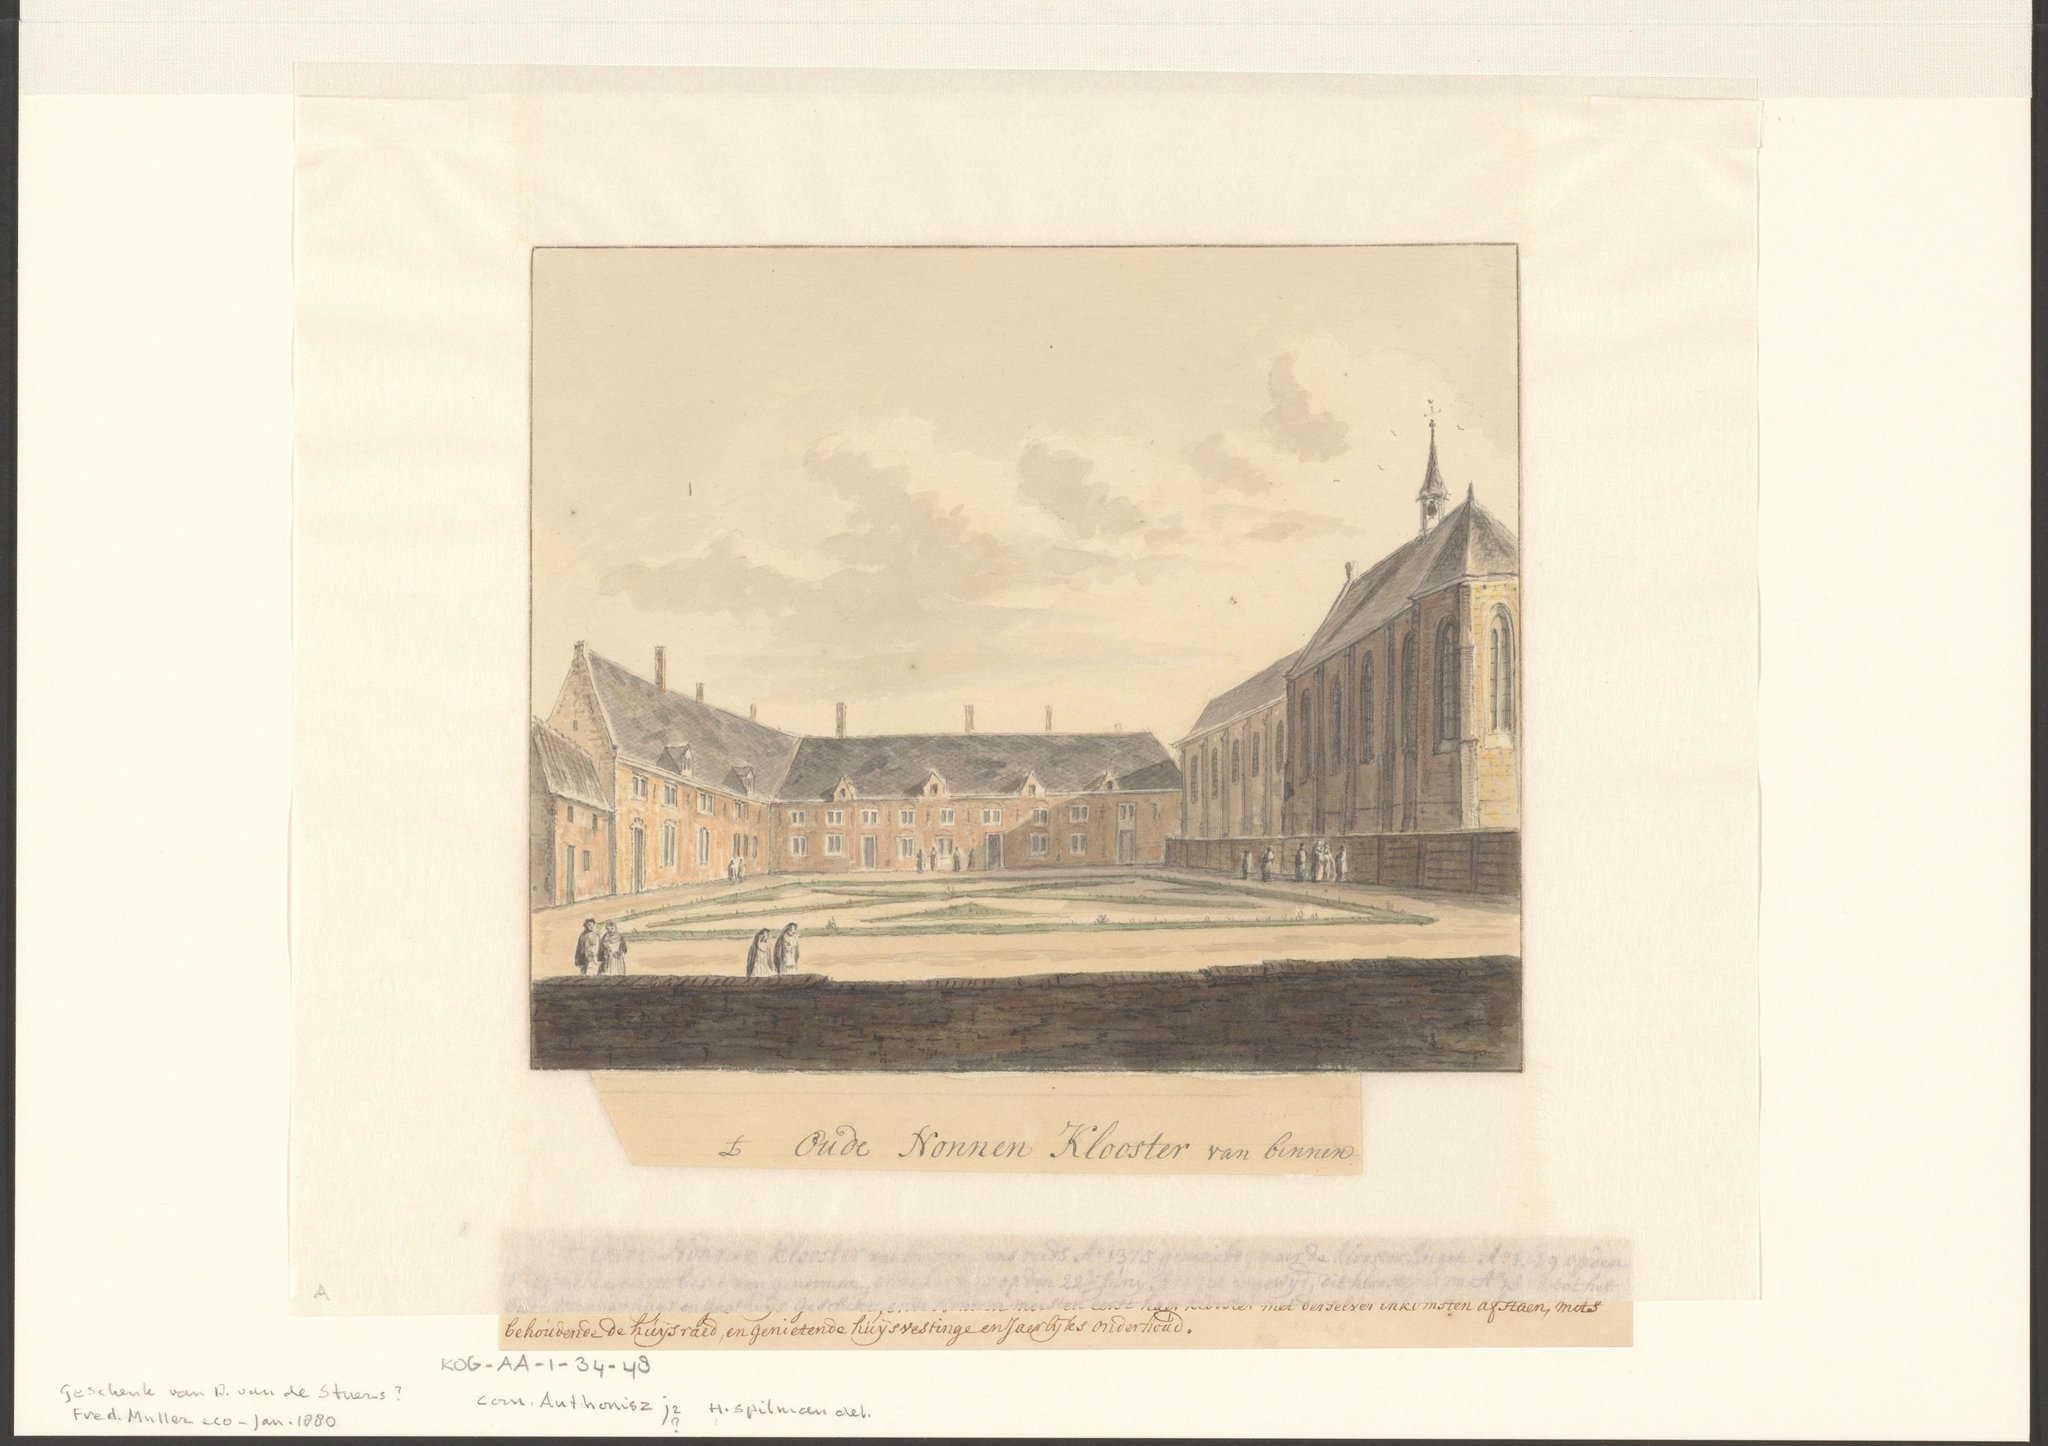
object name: drawing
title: Gezicht op het oude Nonnenklooster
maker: hendrik spilman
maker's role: draughtsman, painter, print maker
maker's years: 1721-1784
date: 1731-1784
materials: ink, paper, pencil, watercolor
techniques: brush, pen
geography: amsterdam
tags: city-view in general; 'veduta', abbey, monastery, convent ~ roman catholic church, abbey garden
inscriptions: signature: ‘Hd. Spilman delin’, inscription: ‘'t Oude Nonnen (...) en Jaarlijks onderhoud.’, inscription: ‘t Oude Nonnen Klooster van binnen’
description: Onderwerpsrubriek binnen de Atlas Amsterdam: Kloosters.